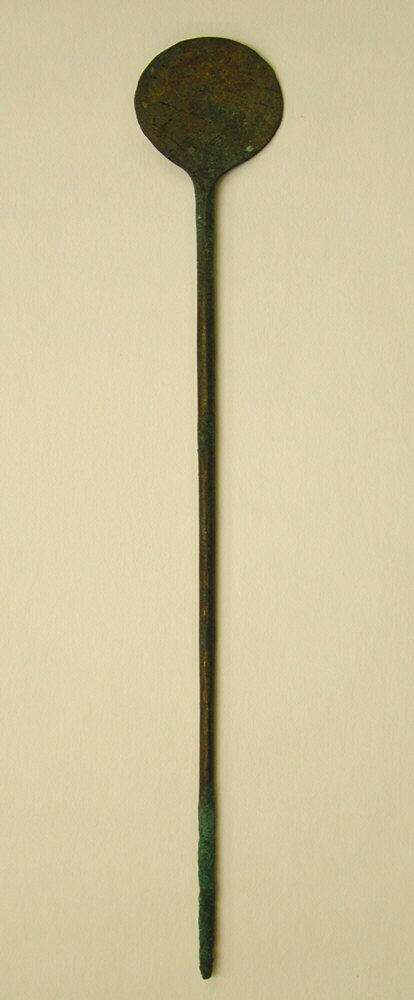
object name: pin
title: Hammered Copper Pin (tupu)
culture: chimú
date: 701-1566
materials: copper, gilt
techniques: hammering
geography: peru